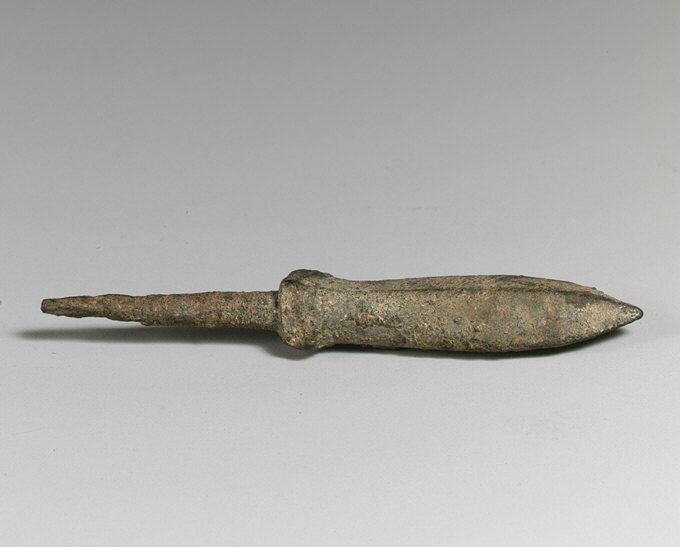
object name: arrowhead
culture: greek, cypriot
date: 480-330 BCE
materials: bronze